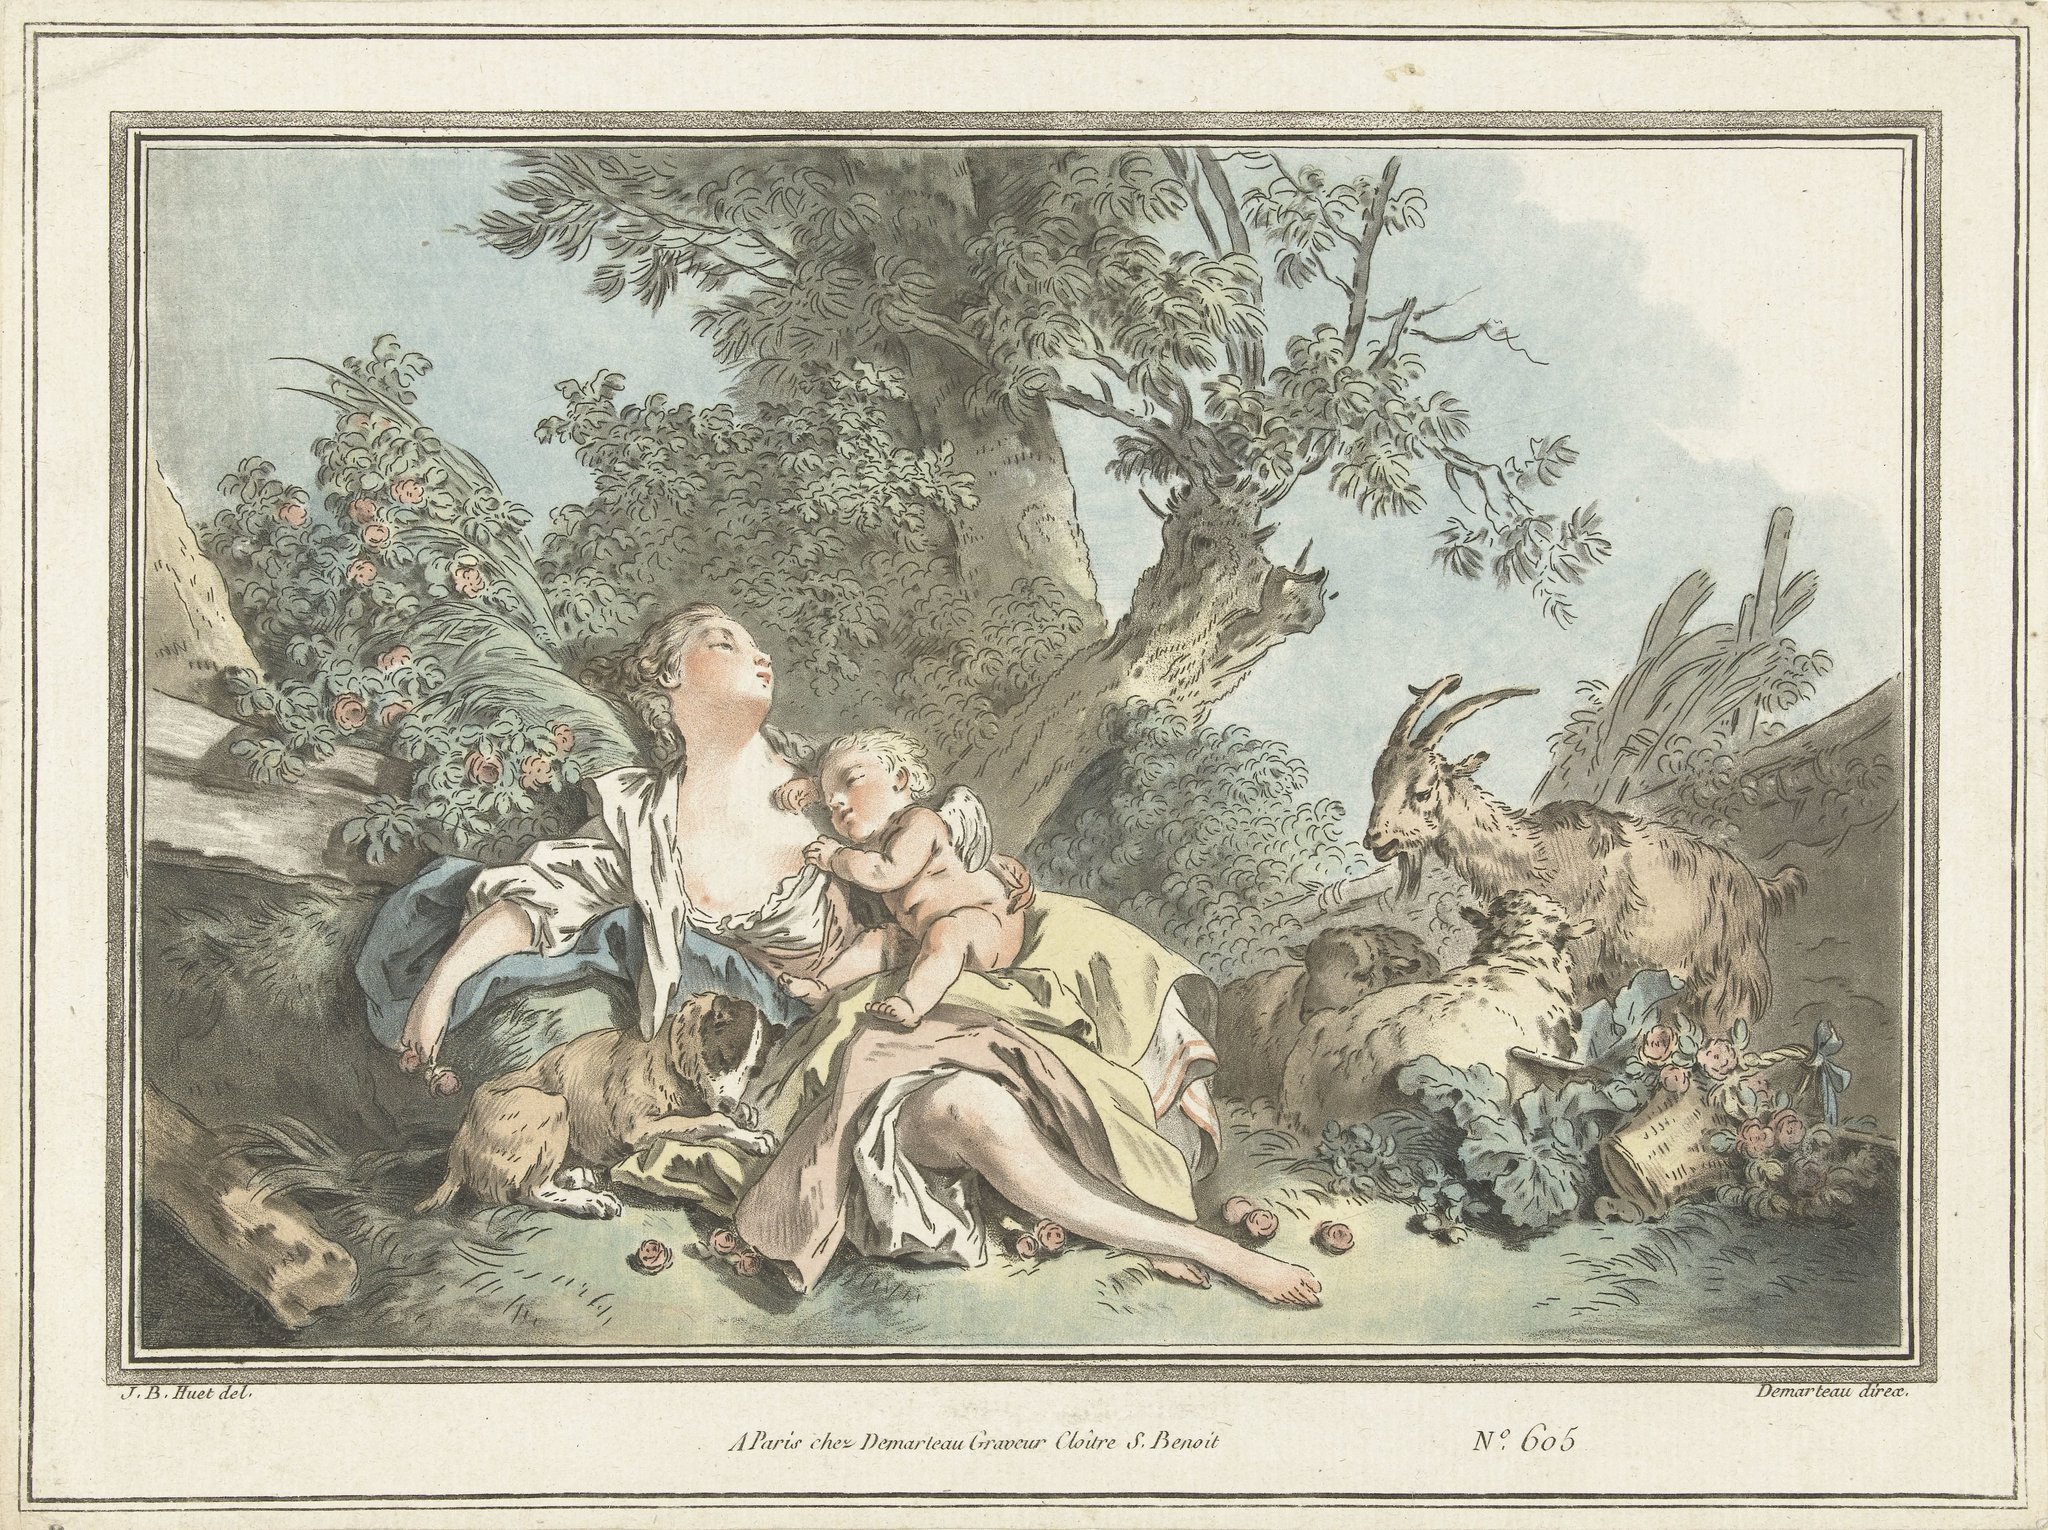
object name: print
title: Slapende herderin en slapende Amor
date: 1760-1802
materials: paper, watercolor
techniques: printmaking, hand coloring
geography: paris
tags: herding, herdsman, herdswoman, shepherd, shepherdess, cowherd, etc., (story of) cupid, amor (eros), sleeping; unconsciousness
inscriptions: collector's mark: Lugt 2228, number: ‘No. 605’, collector's mark: Lugt 2760